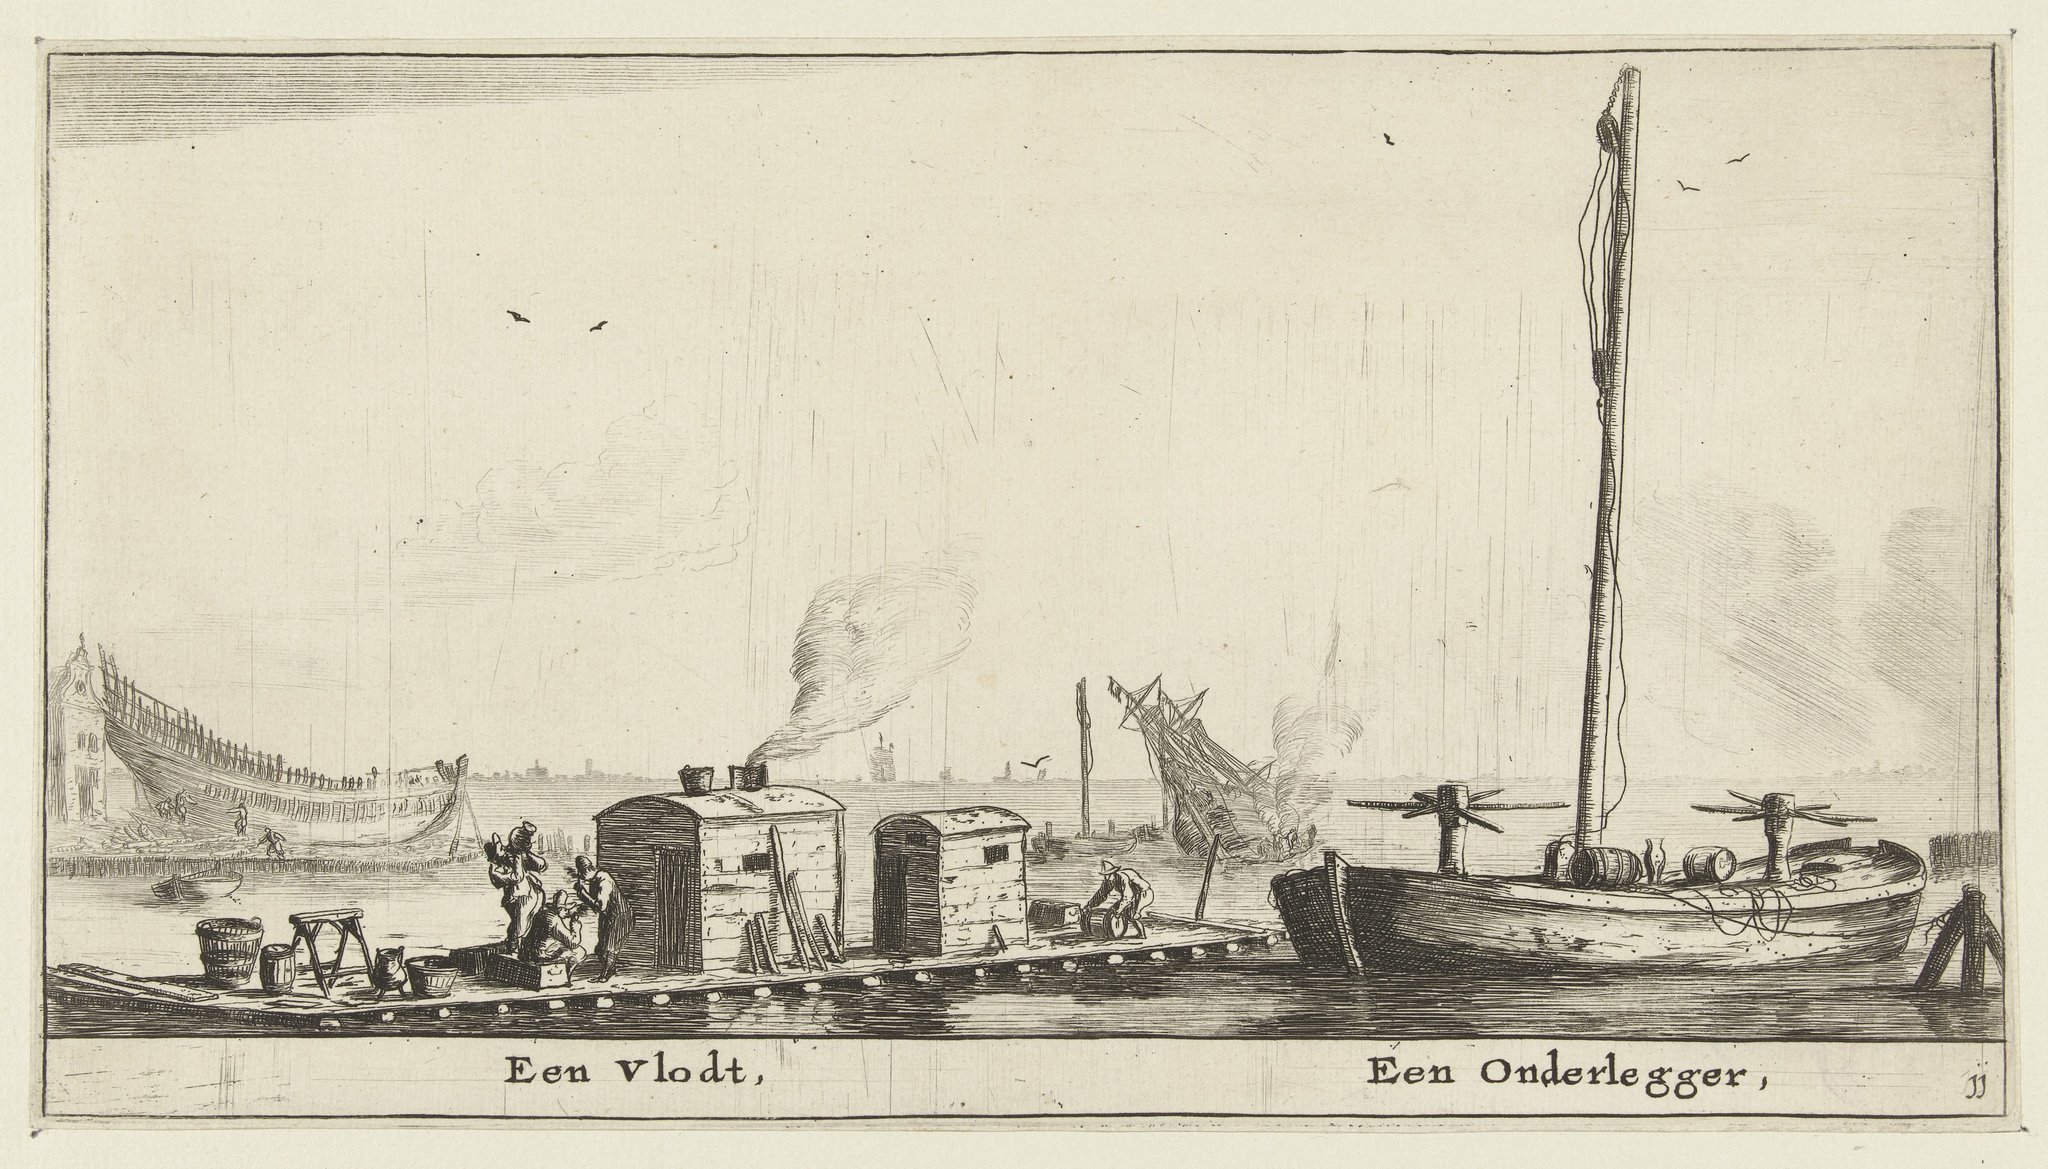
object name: print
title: Derde deel. Verscheijden Schepen en Gesichten van Amsterdam, naer t leven afgetekent en opt Cooper gebracht, door Reinier Nooms, alias Zeeman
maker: reinier nooms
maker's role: draughtsman, painter, print maker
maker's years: 1623-1664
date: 1652-1654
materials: paper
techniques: drypoint, etching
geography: netherlands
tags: repairing, caulking, careening (~ ship), raft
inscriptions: collector's mark: Lugt 12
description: Een vlot met twee hutten en vier mannen. Daarnaast een onderlegger. Op de achtergrond een onderlegger in gebruik: een groot schip wordt schuin getrokken om reparaties en onderhoud aan het onderwaterschip te kunnen uitvoeren. Links een scheepswerf met een schip in aanbouw.